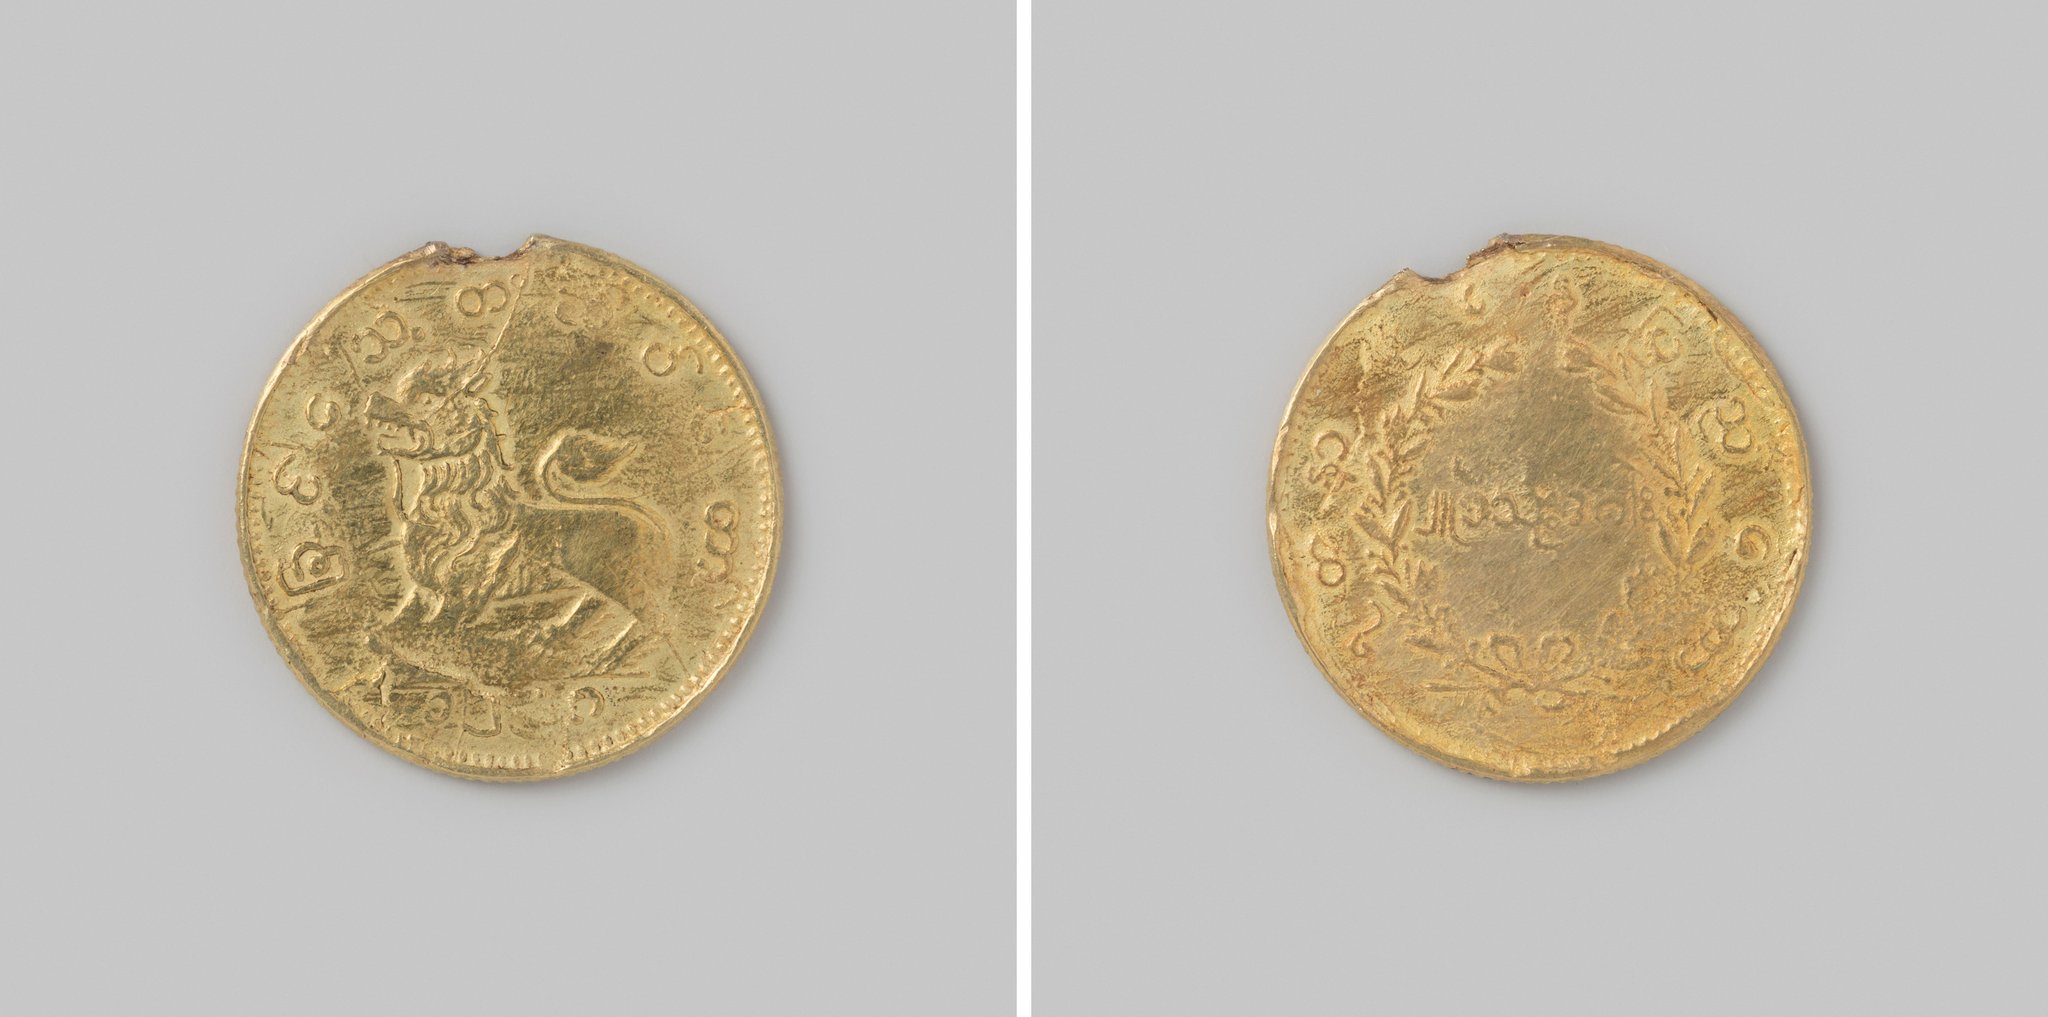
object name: kwart mohur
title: Kwart mohur uit Birma van Mindon Min, 1228 [=1866]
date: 1866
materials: gold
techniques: striking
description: Gouden munt. Voorzijde: een Birmese leeuw. Daaronder jaartal: 1228. Keerzijde: tussen twee samengebonden takken waarde-aanduiding in een regel. Kartelrand. NB: muntplaatje beschadigd door verwijderde montage.